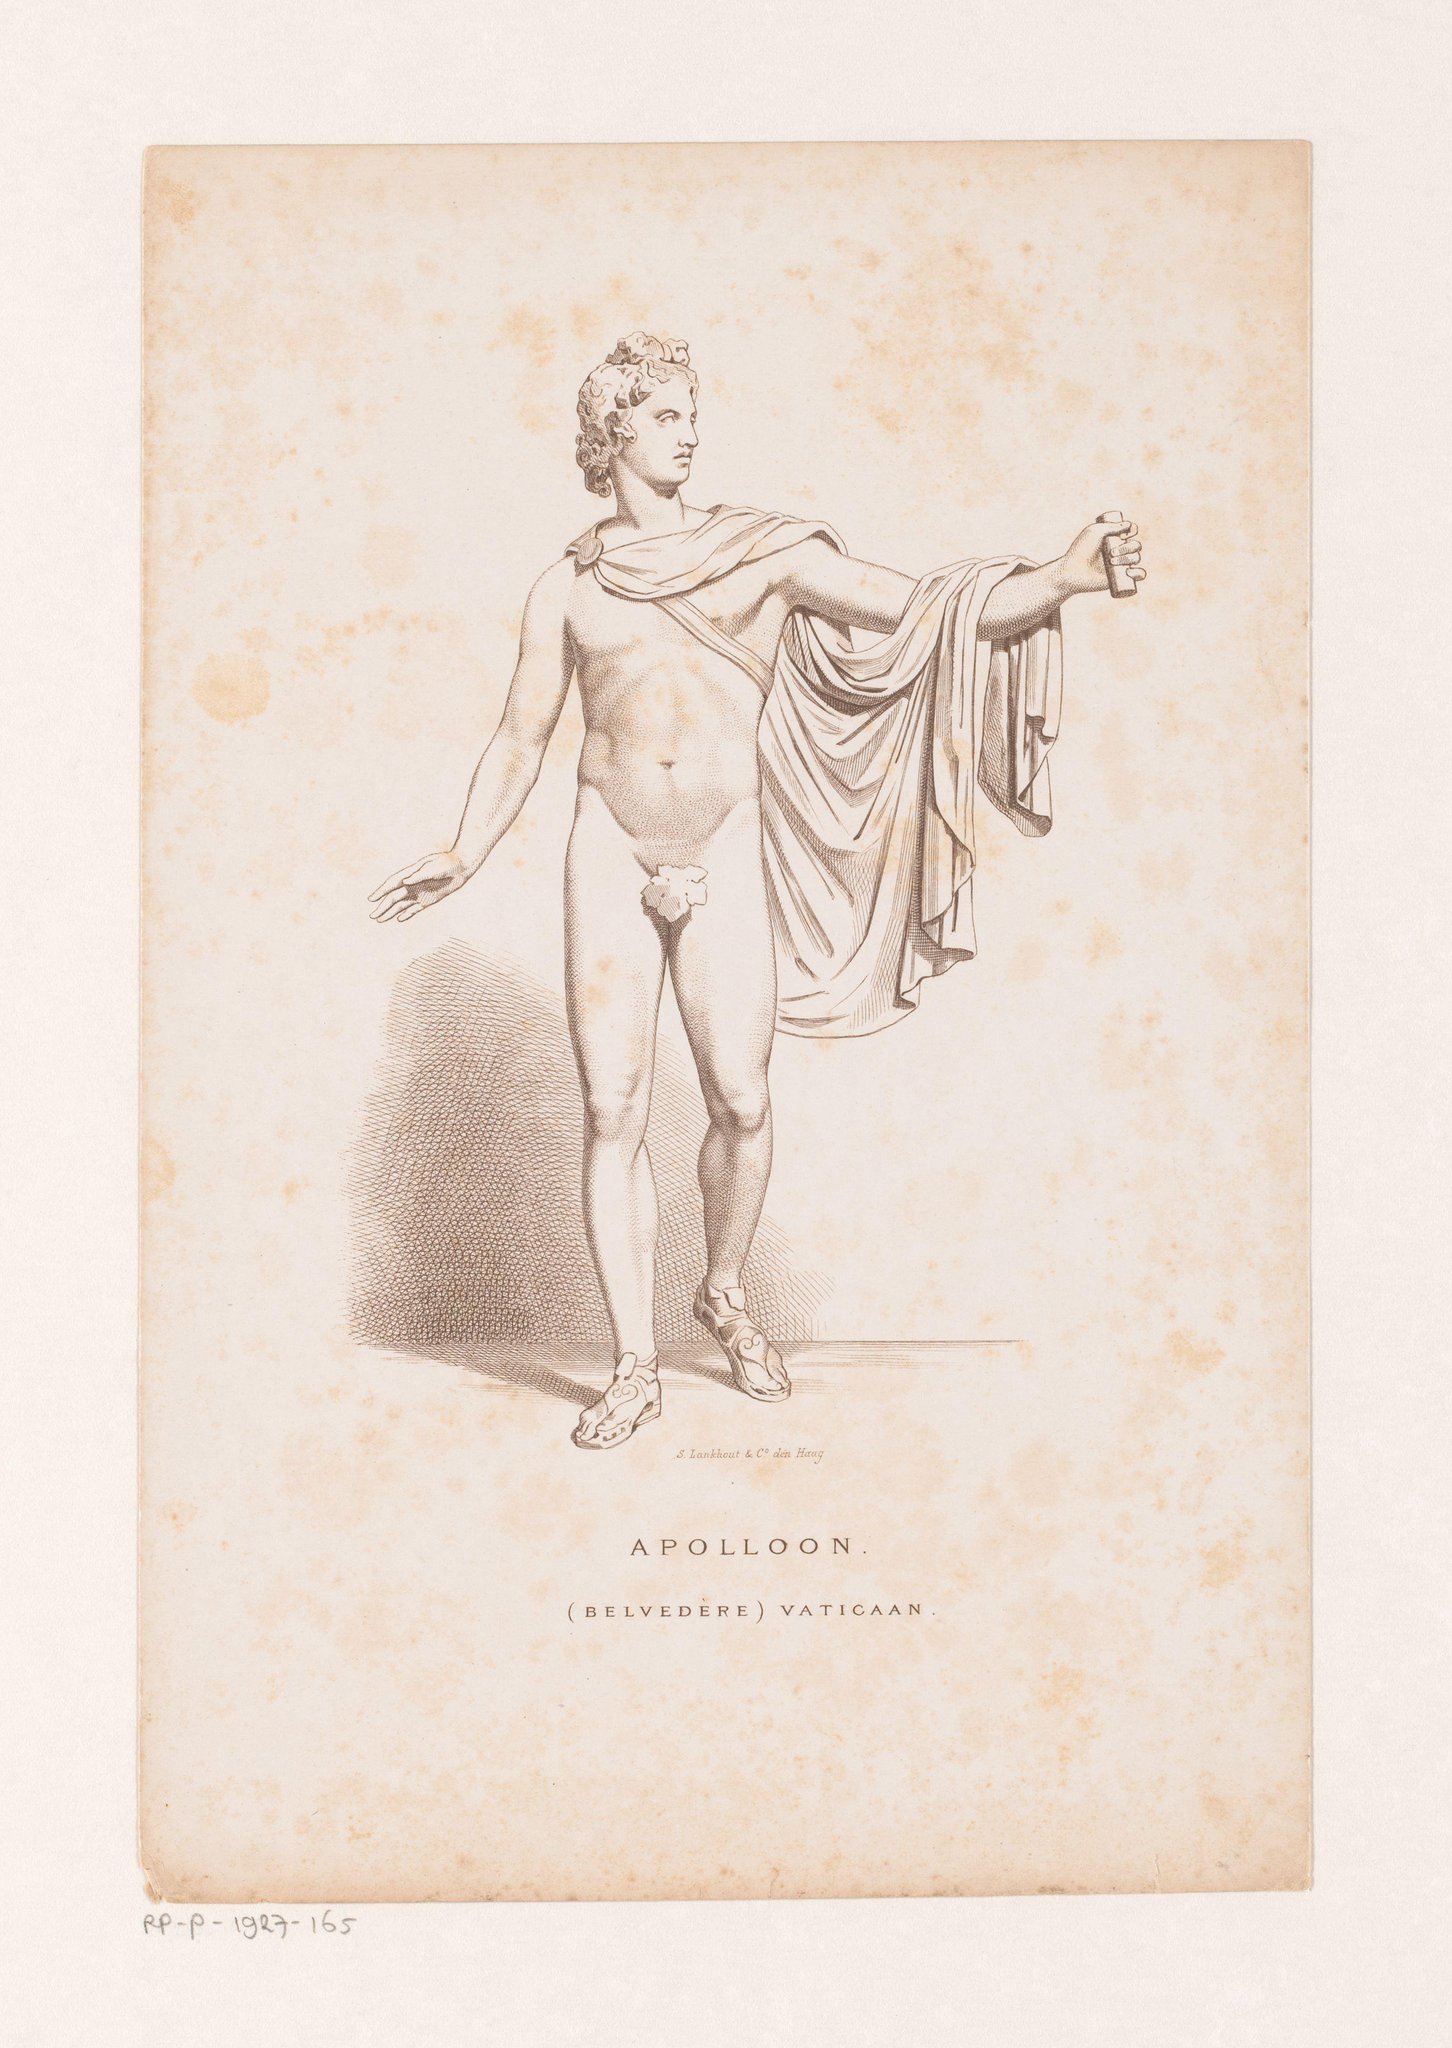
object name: print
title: Apollo van Belvedère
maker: Anonymous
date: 1877-1903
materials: paper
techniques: lithograph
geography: the hague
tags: (story of) apollo (phoebus)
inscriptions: collector's mark: Lugt 2233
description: Maakte waarschijnlijk deel uit van een serie, zie RP-P-1927-164, RP-P-1927-165 en RP-P-1927-166.